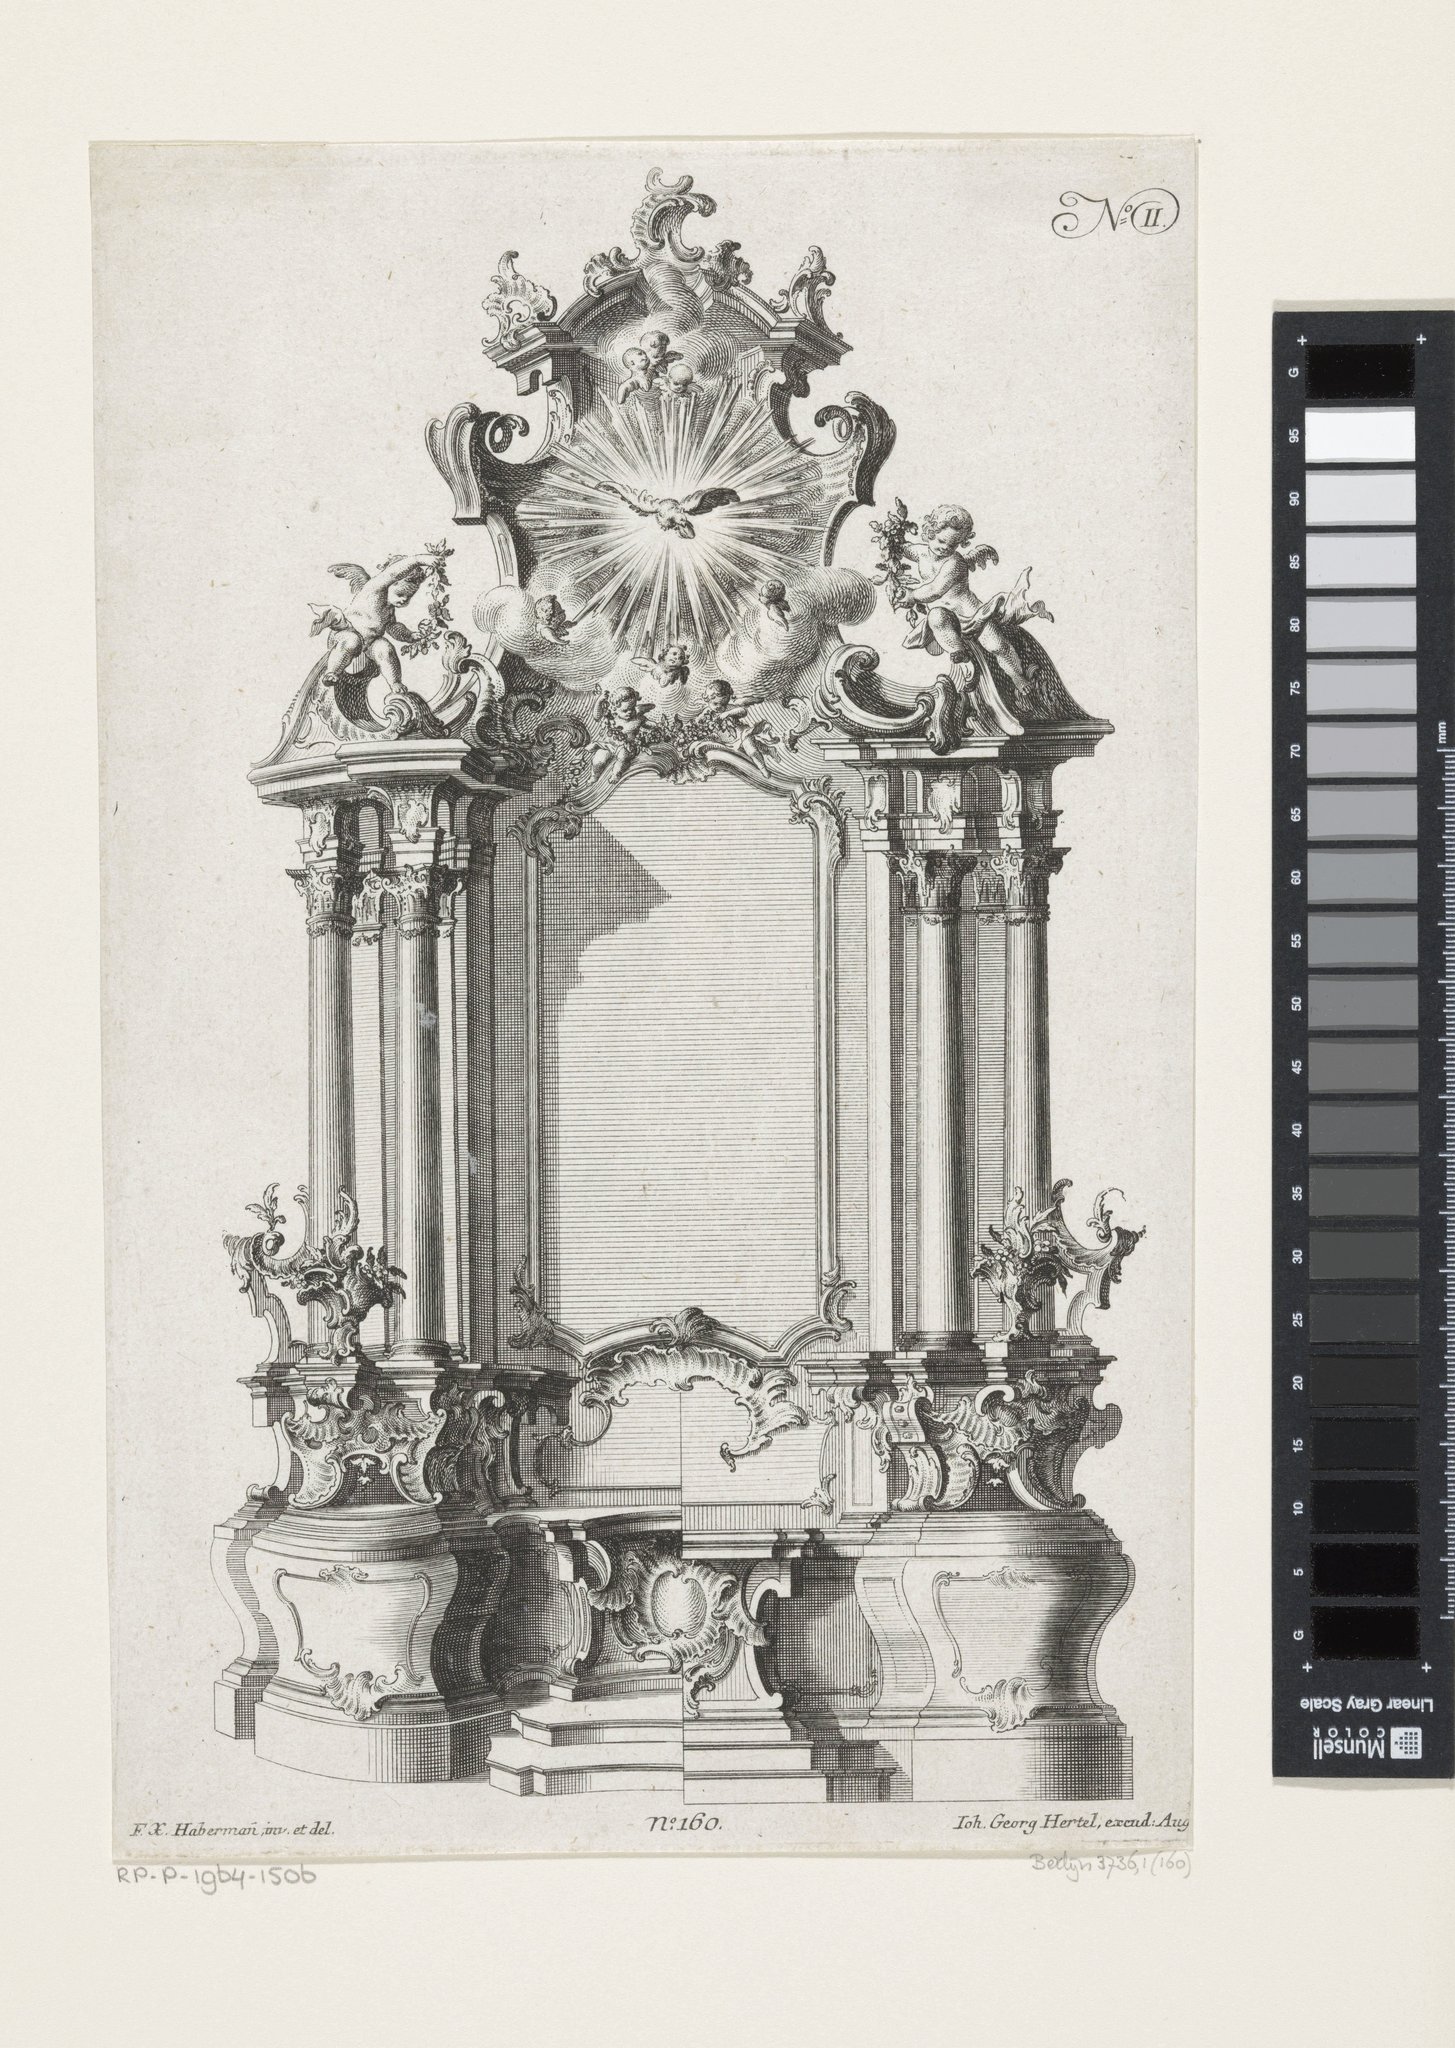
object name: ornament print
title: Altaar met Heilige Geest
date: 1731-1775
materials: paper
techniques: engraving, etching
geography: augsburg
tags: altar, cupids: 'amores', 'amoretti', 'putti', holy ghost represented as a dove (in flames)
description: Altaar met rocaille ornamenten en duif in stralenkrans als symbool van de Heilige Geest. Links en rechts gevleugelde putti met guirlandes. Uitgeversnummer 160.